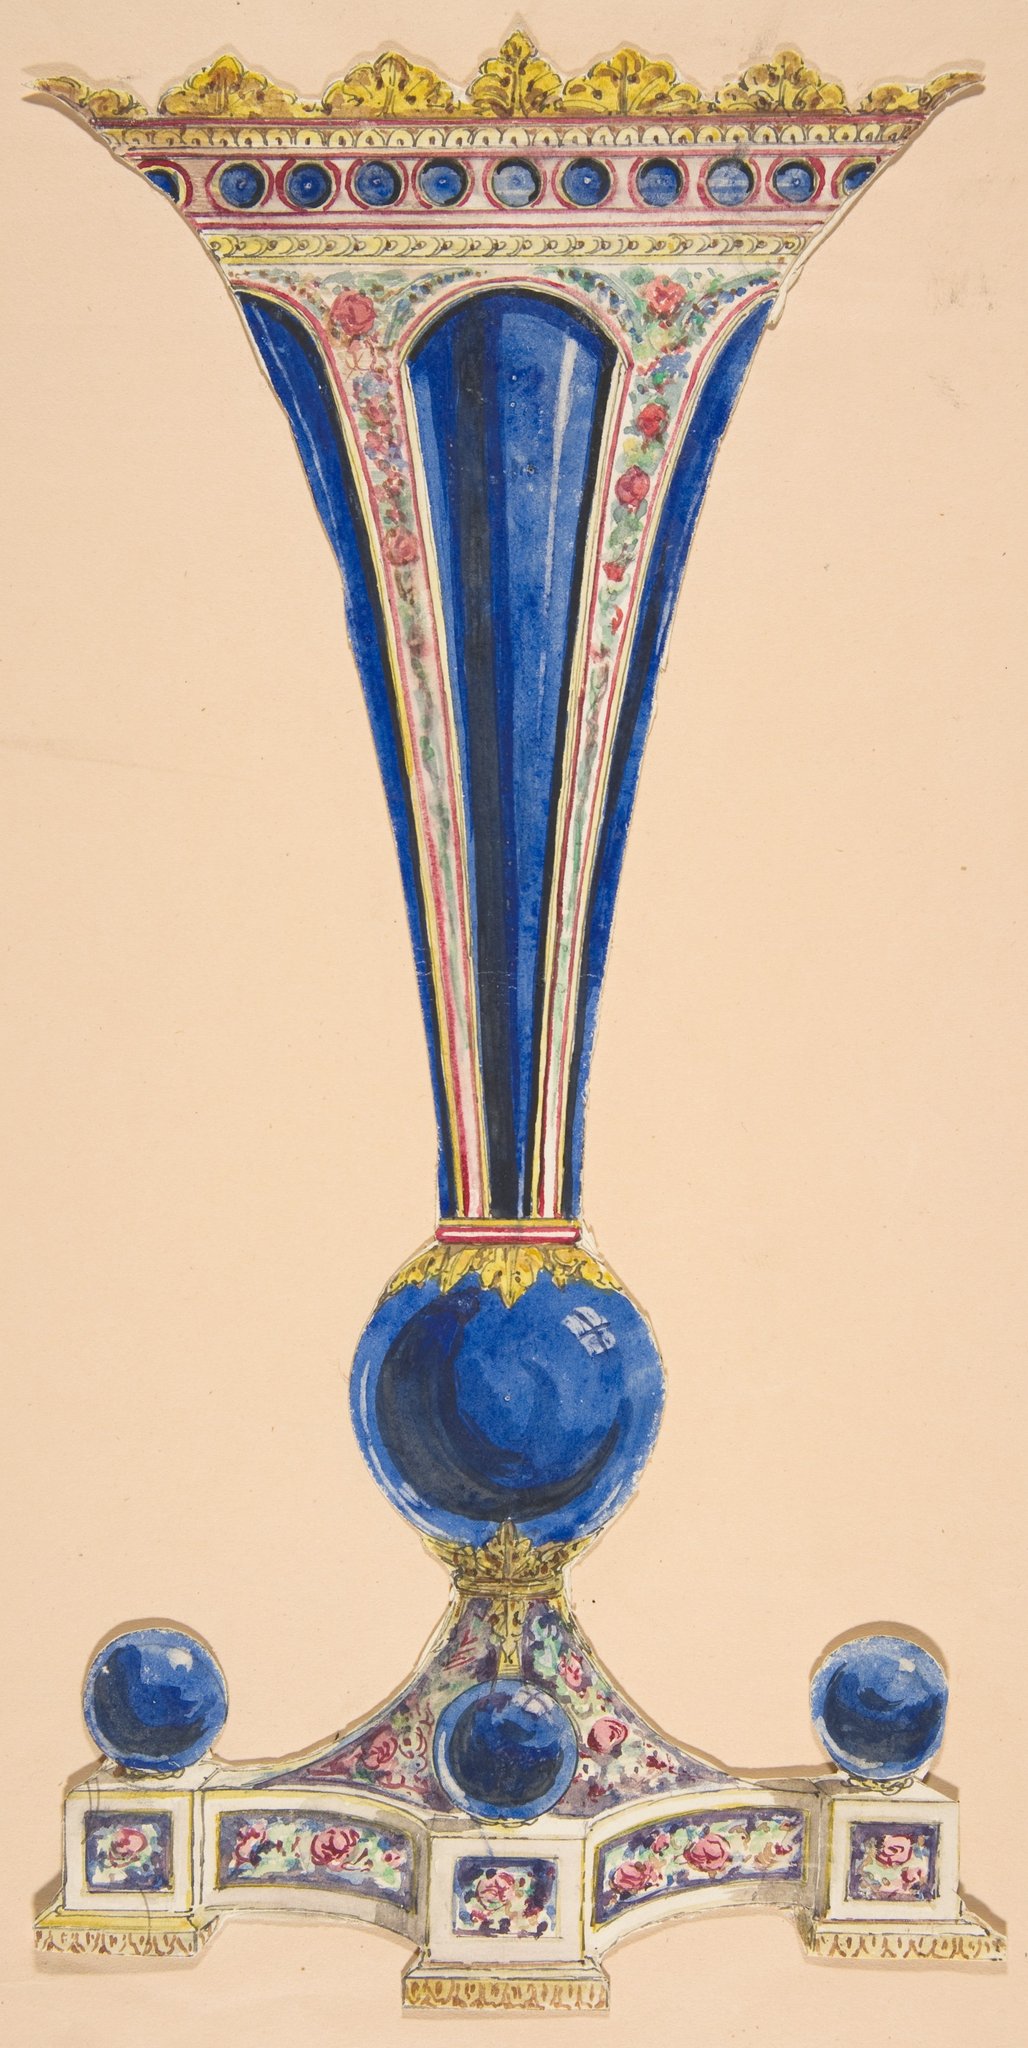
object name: drawing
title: Design for a Vase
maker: anonymous, french, 19th century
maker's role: artist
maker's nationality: french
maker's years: 1800-1900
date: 1801-1900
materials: ink, paper, watercolor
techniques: pen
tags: flowers,vases